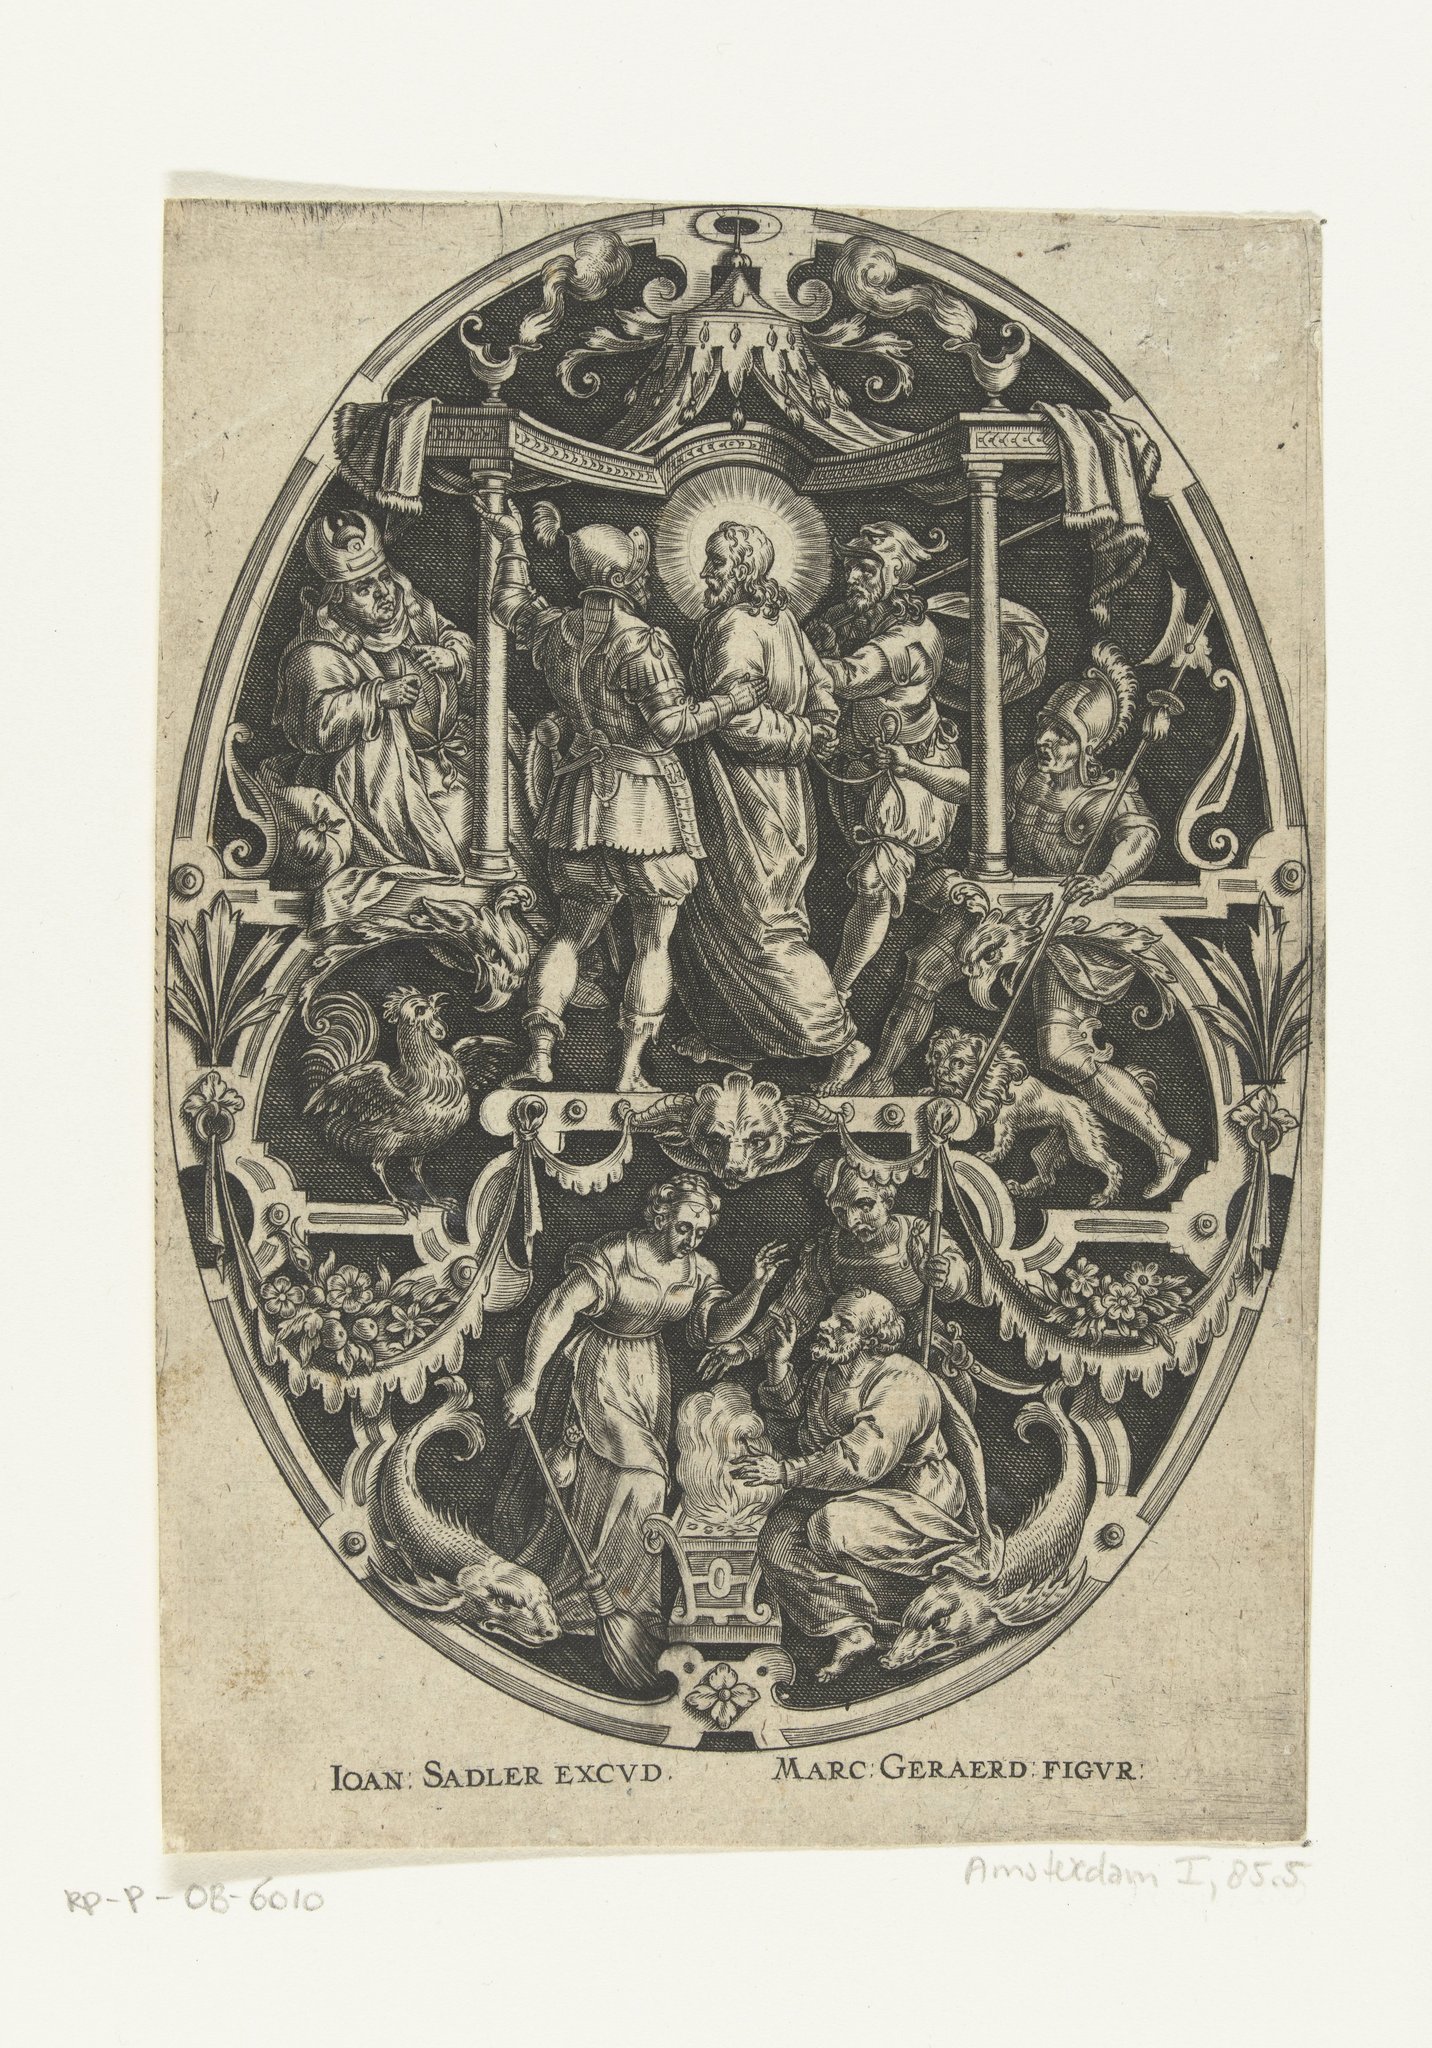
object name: print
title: Passio verbigenae quae redeptio Christ (...)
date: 1560-1600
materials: paper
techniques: engraving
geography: netherlands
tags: christ is led away ~ garden of gethsemane, peter denies christ, usually before a girl-servant and some soldiers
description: Onderaan de verloochening van Christus door Petrus. Gearceerde achtergrond. Uit serie van 14 ovalen met grotesken waarin scènes uit de passie zijn afgebeeld.